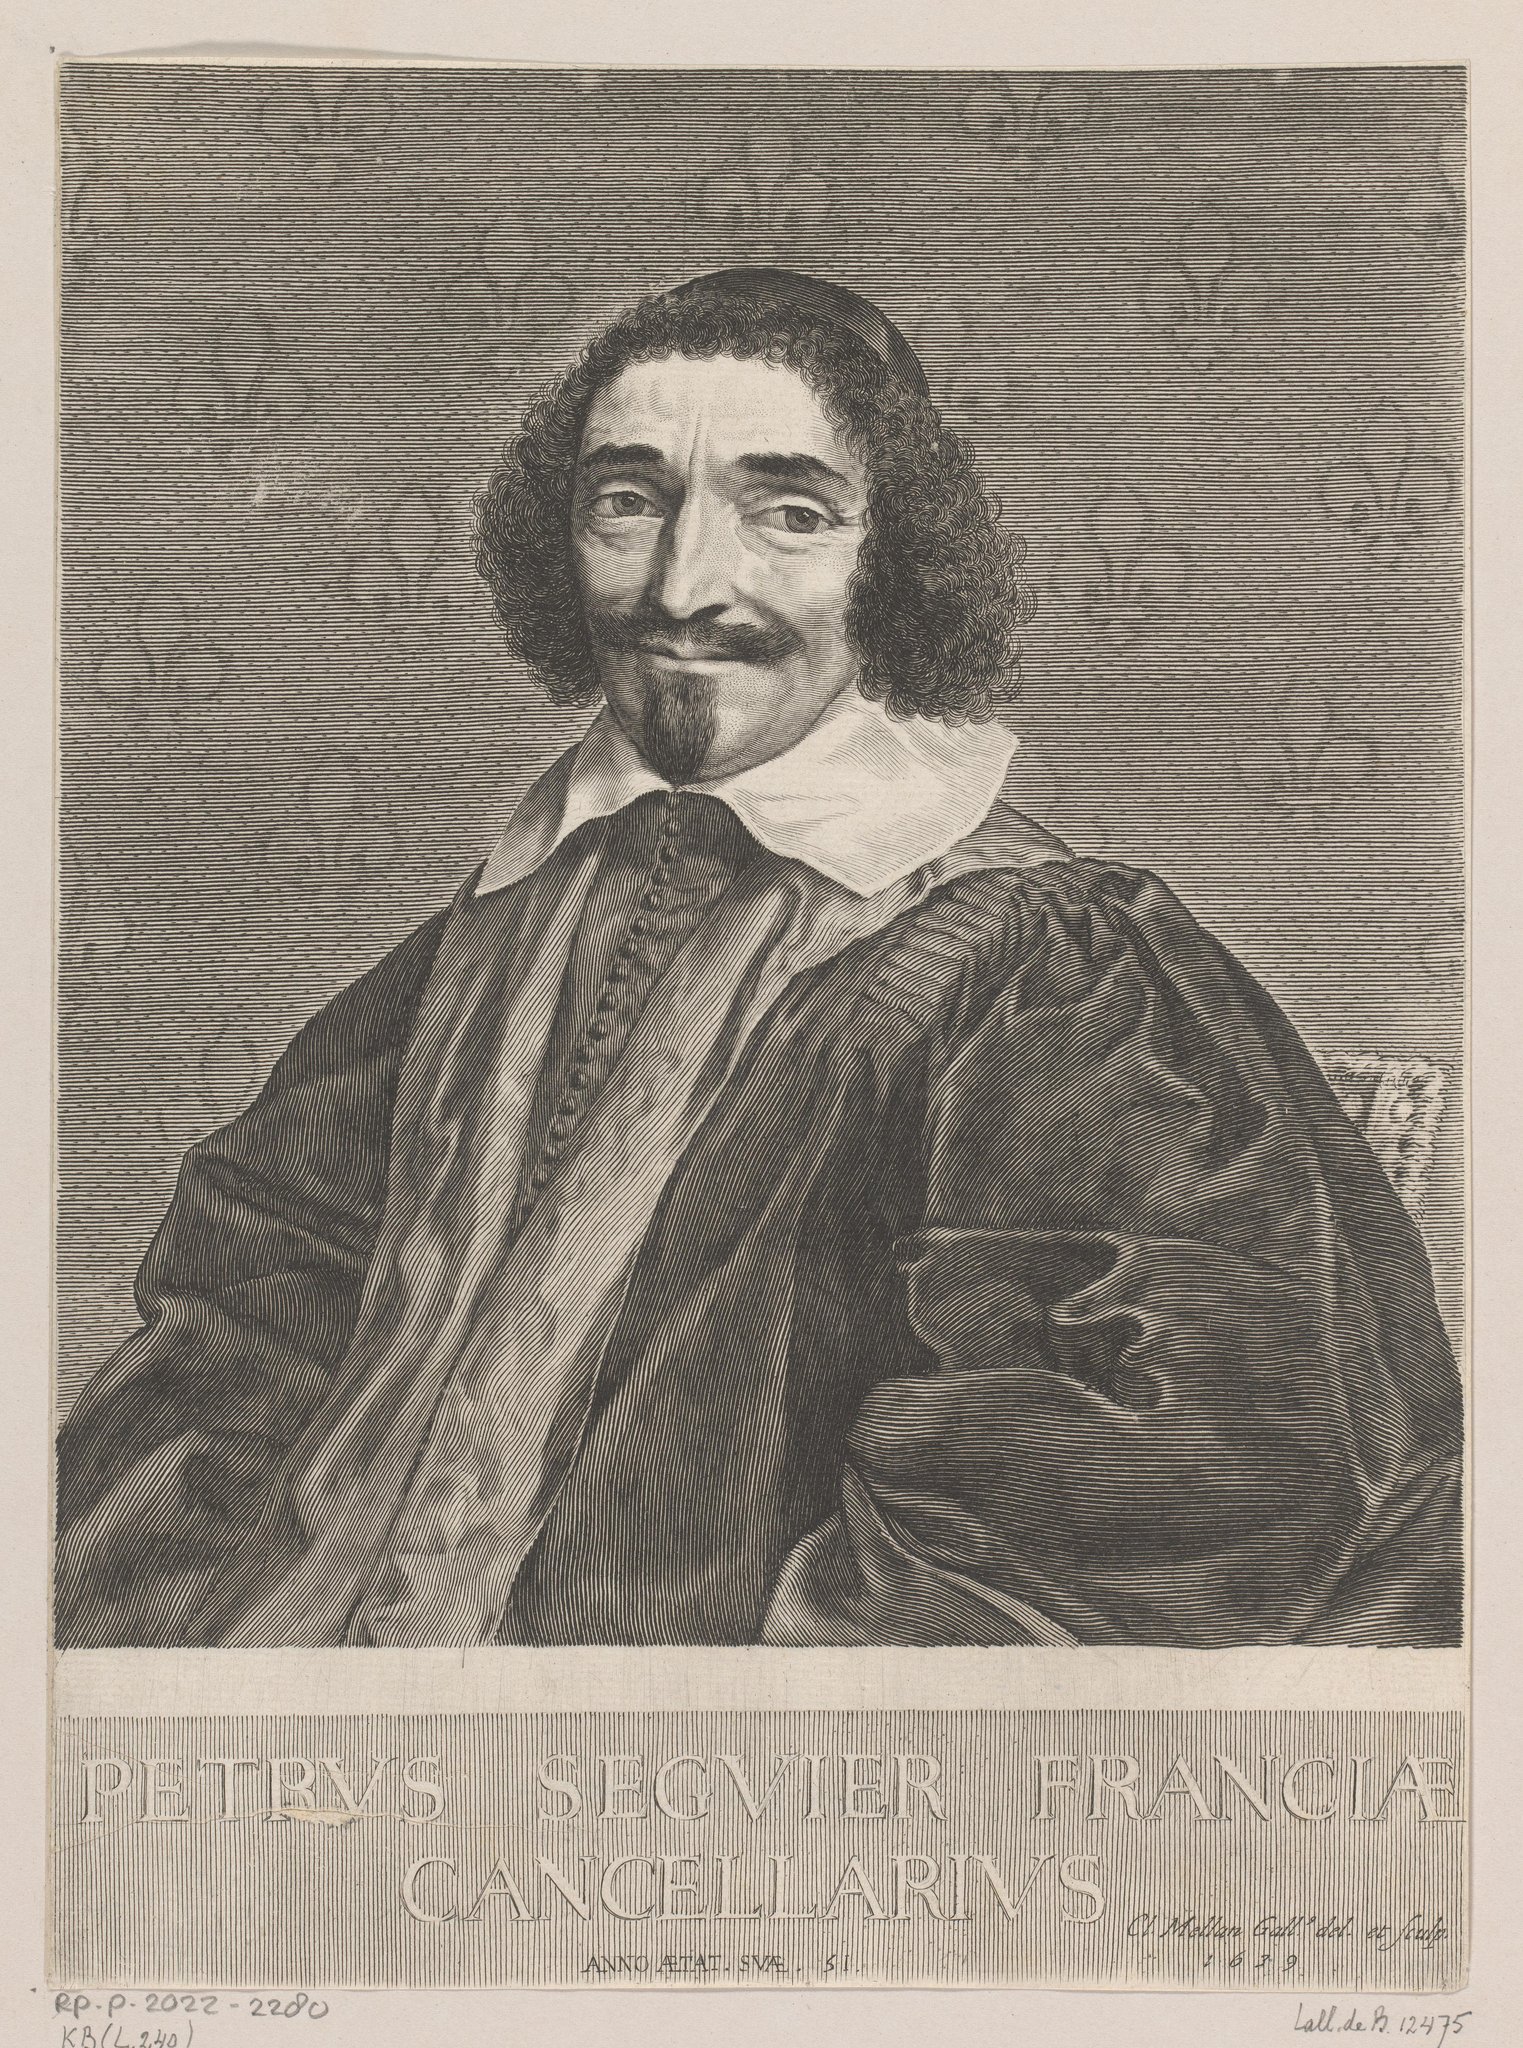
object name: print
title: Portret van Pierre Séguier op 51-jarige leeftijd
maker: claude mellan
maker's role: draughtsman, print maker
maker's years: 1598-1688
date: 1639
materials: paper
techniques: engraving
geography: france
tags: paris, pierre séguier, historical persons, politician, e.g. party leader, diplomacy, diplomat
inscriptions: collector's mark: Lugt 240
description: Met tweeregelig onderschrift in het Latijn.